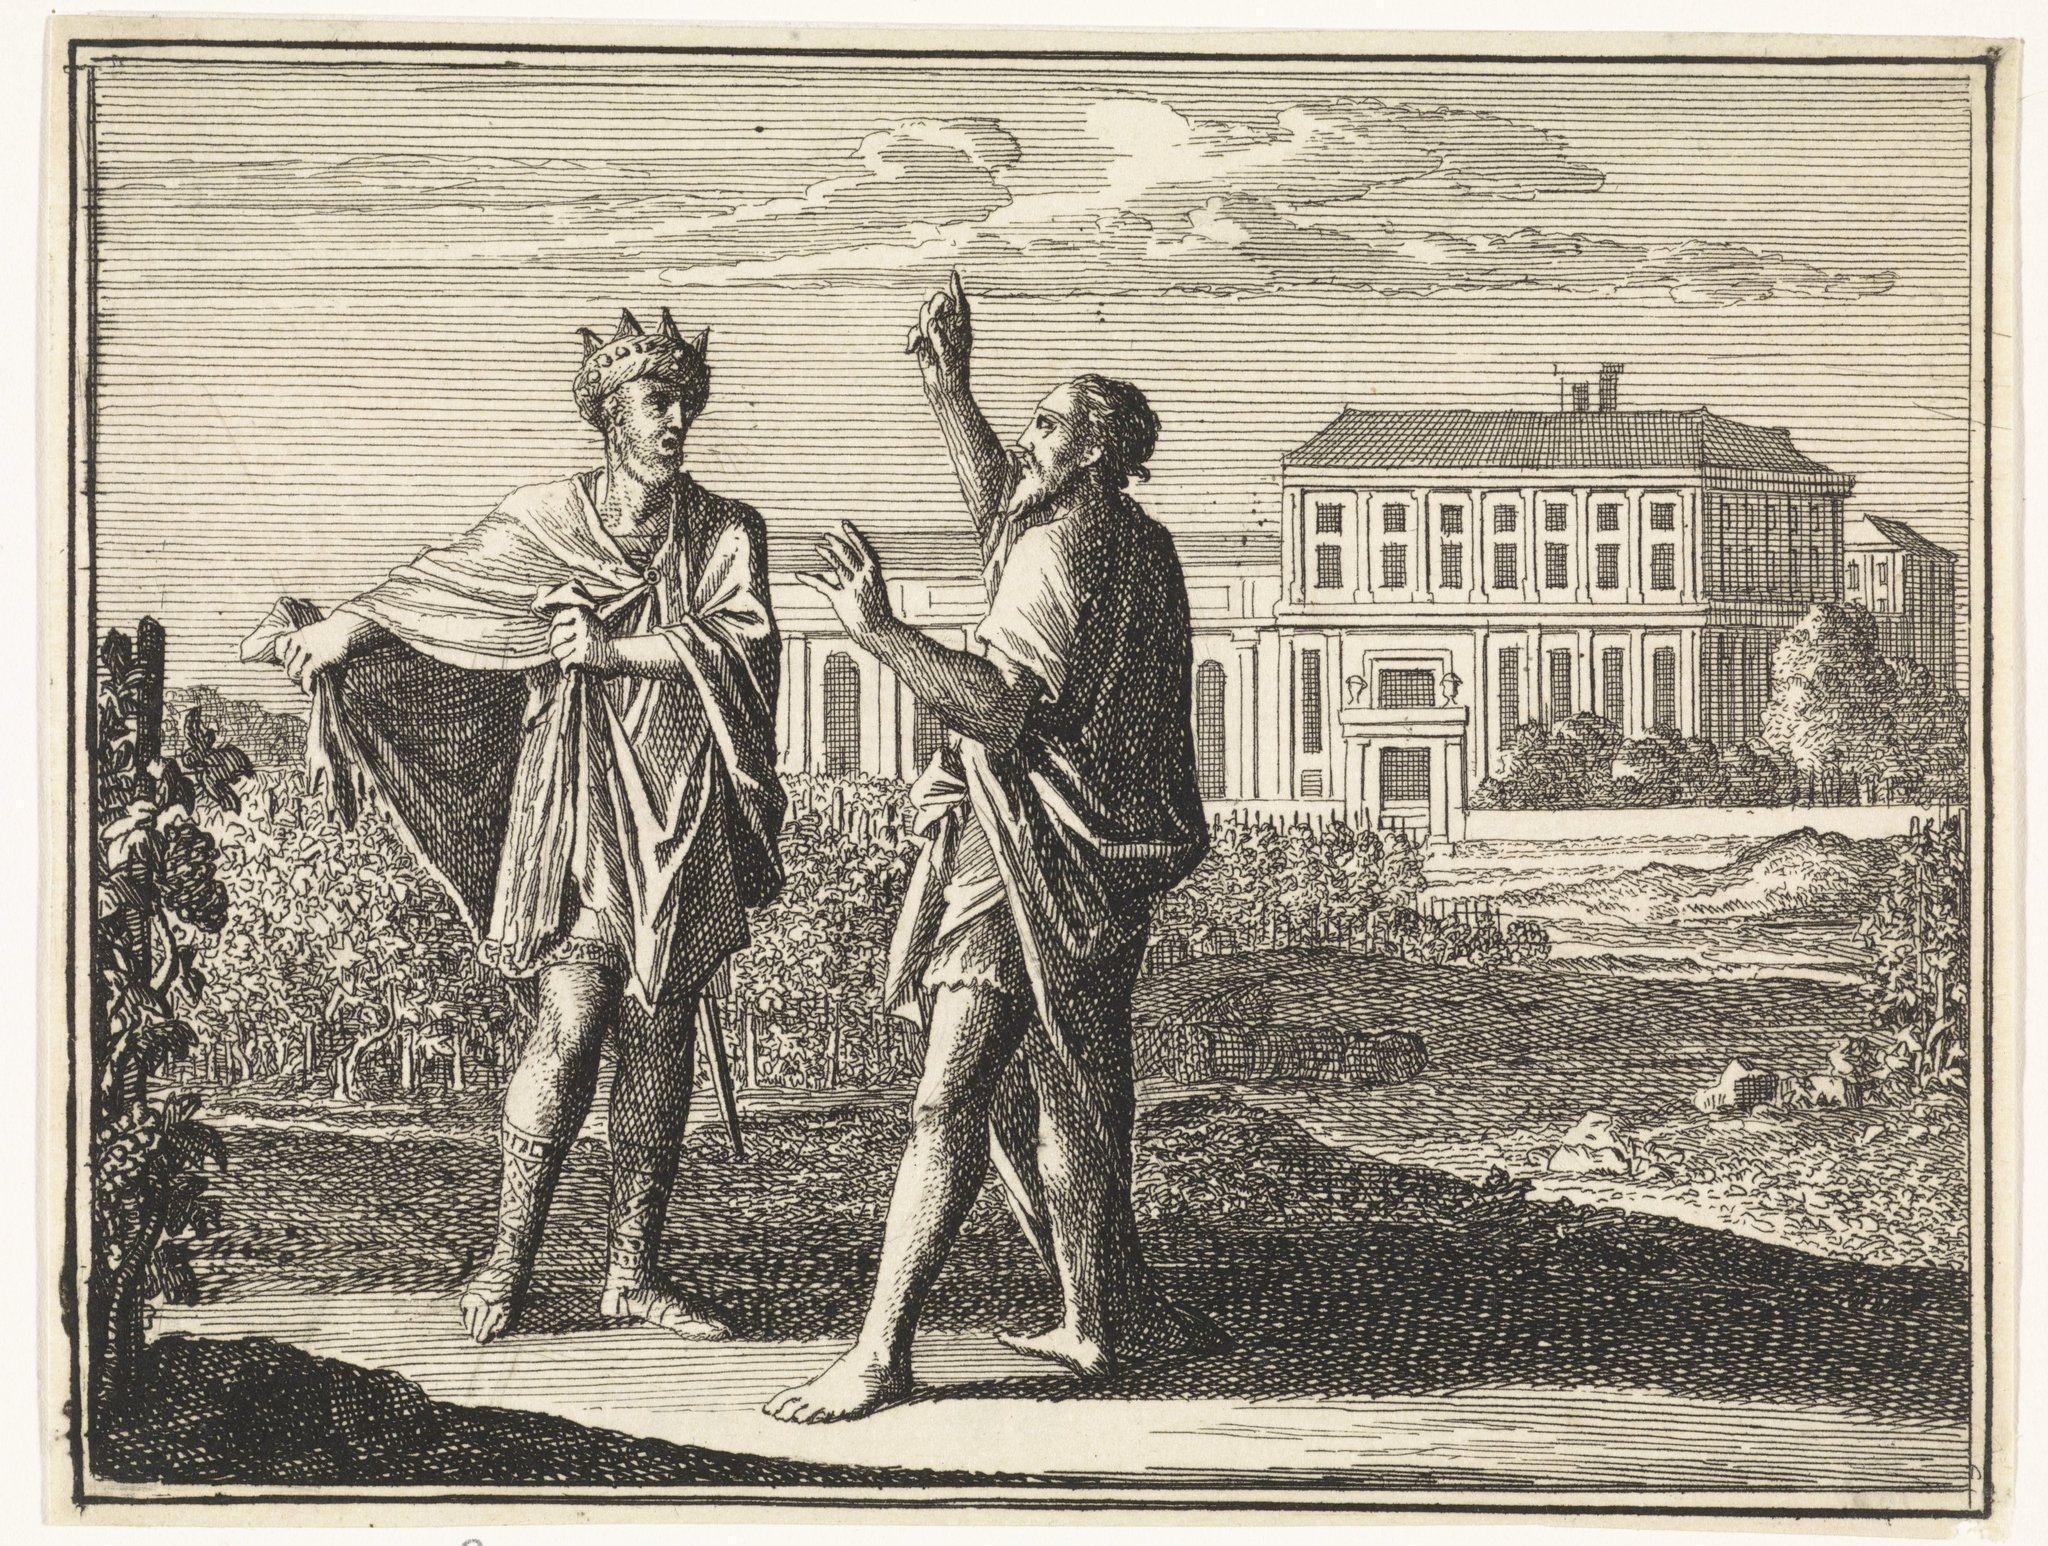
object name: print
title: Elia bestraft Achab in de wijngaard van Nabot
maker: caspar luyken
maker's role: draughtsman, print maker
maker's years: 1672-1708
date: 1712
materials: paper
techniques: etching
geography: amsterdam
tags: ahab, when taking possession of the vineyard, is condemned by elijah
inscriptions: collector's mark: Lugt 2228, number: ‘138’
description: Illustratie uit: Luyken, Jan. De schriftuurlyke geschiedenissen en gelykenissen van het Oude en Nieuwe Verbond, 2 delen. Amsterdam: Wed. Pieter Arentsz II en Cornelis van der Sys, 1712, dl. I.